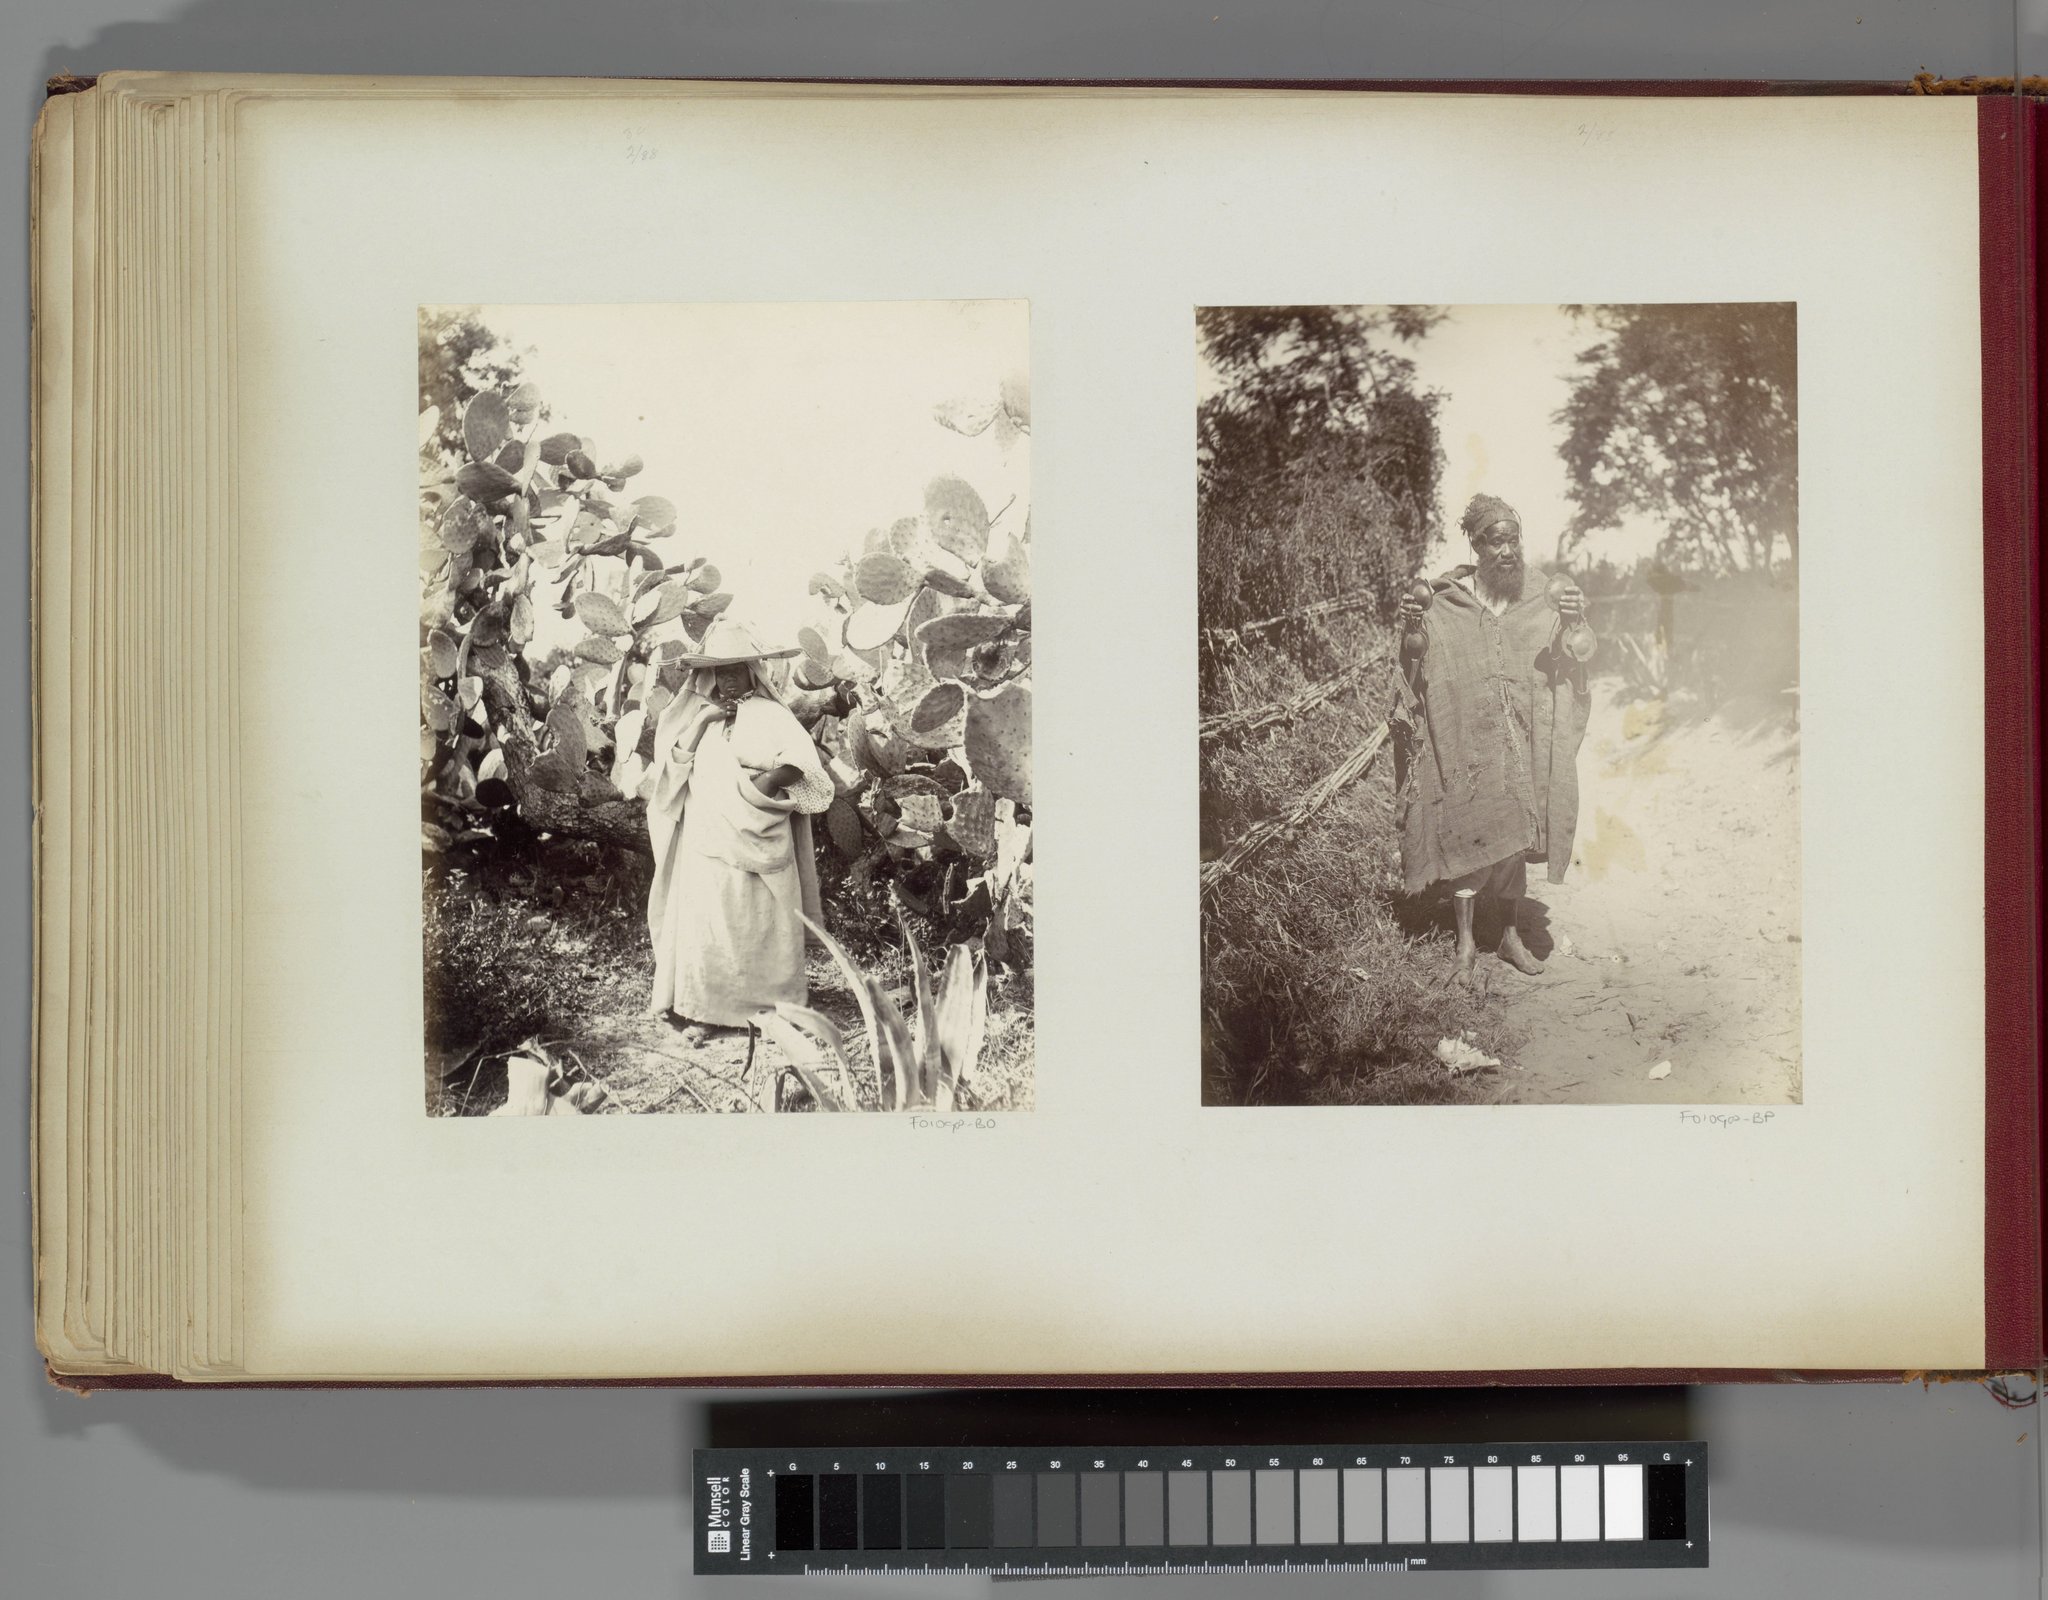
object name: photograph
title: Portret van een in vodden geklede man met een klepper op een zandweg in Marokko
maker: antonio cavilla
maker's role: fotograaf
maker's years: 1867-1908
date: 1880-1910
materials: cardboard, paper, photographic support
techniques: albumen print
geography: north africa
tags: clothed in rags, clappers, castanets - cc - out of doors, beggar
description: Onderdeel van Reisalbum met foto's van bezienswaardigheden in Spanje en Marokko.